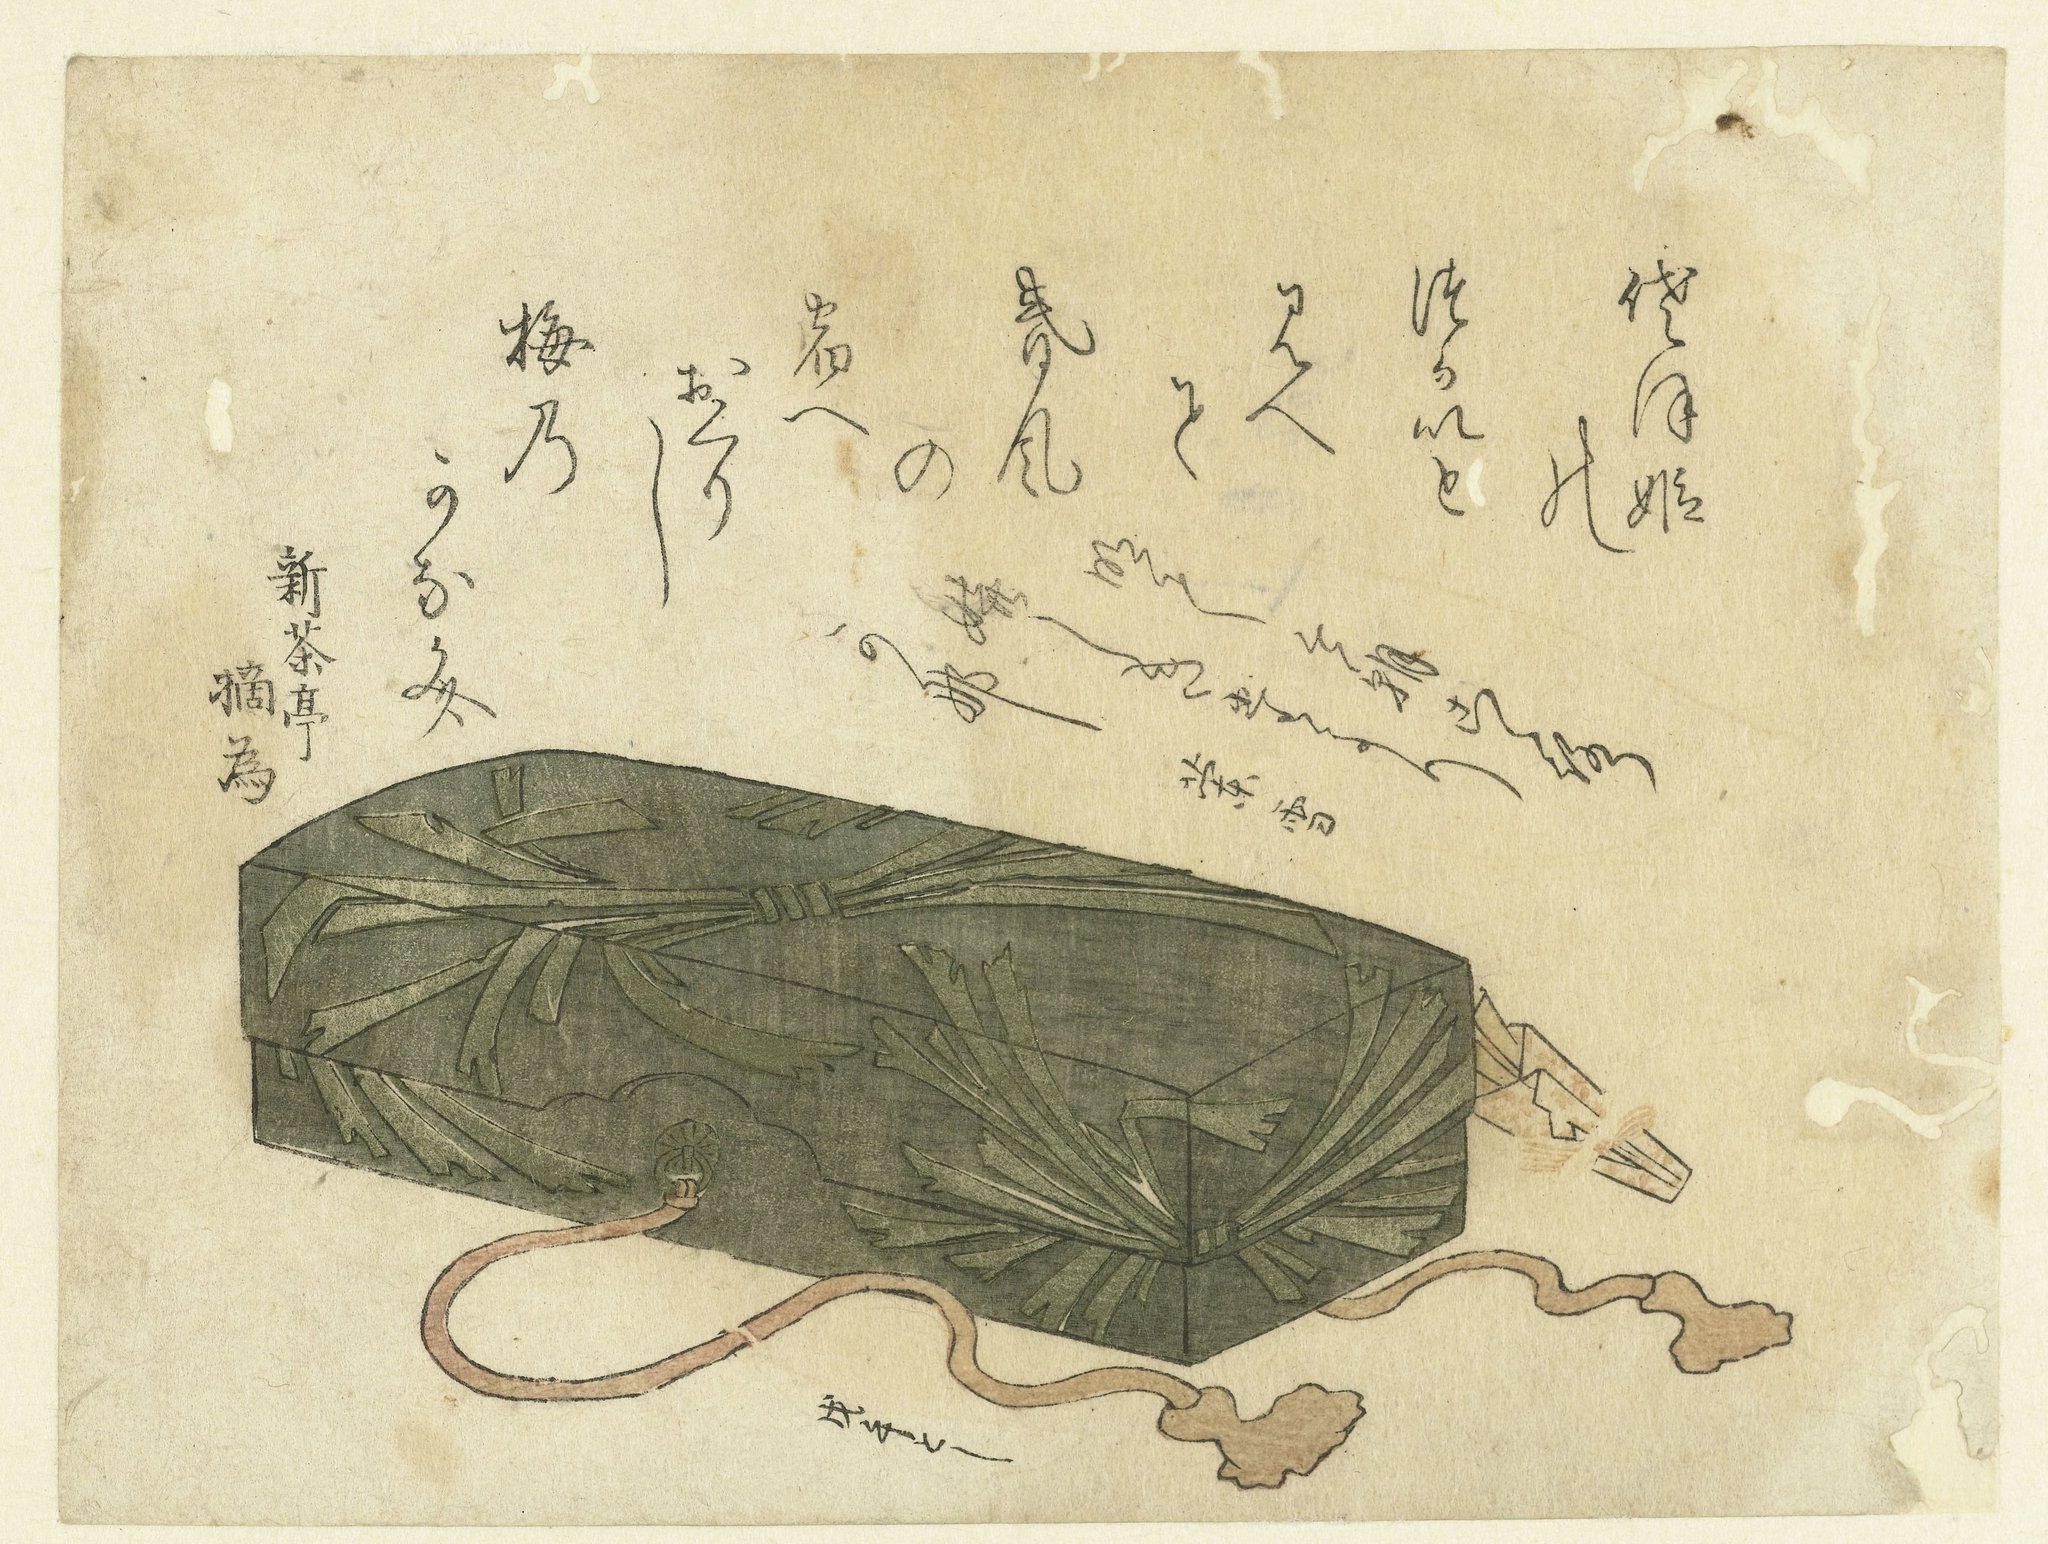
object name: surimono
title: A Lacquered Letterbox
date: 1798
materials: paper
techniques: blind stamped, woodcut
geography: japan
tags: wooden container: barrel, cask, bucket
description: Een surimono is een luxe uitgevoerde prent waarop beeld met één of meerdere gedichten gecombineerd is. Bij het drukken van een surimono werd vaak gebruik gemaakt van dikker papier, blinddruk en metaal pigmenten, zoals koper- en zilverpoeder. De prenten werden vaak in opdracht van dichters gemaakt en als exclusief geschenk aan vrienden en relaties gegeven.